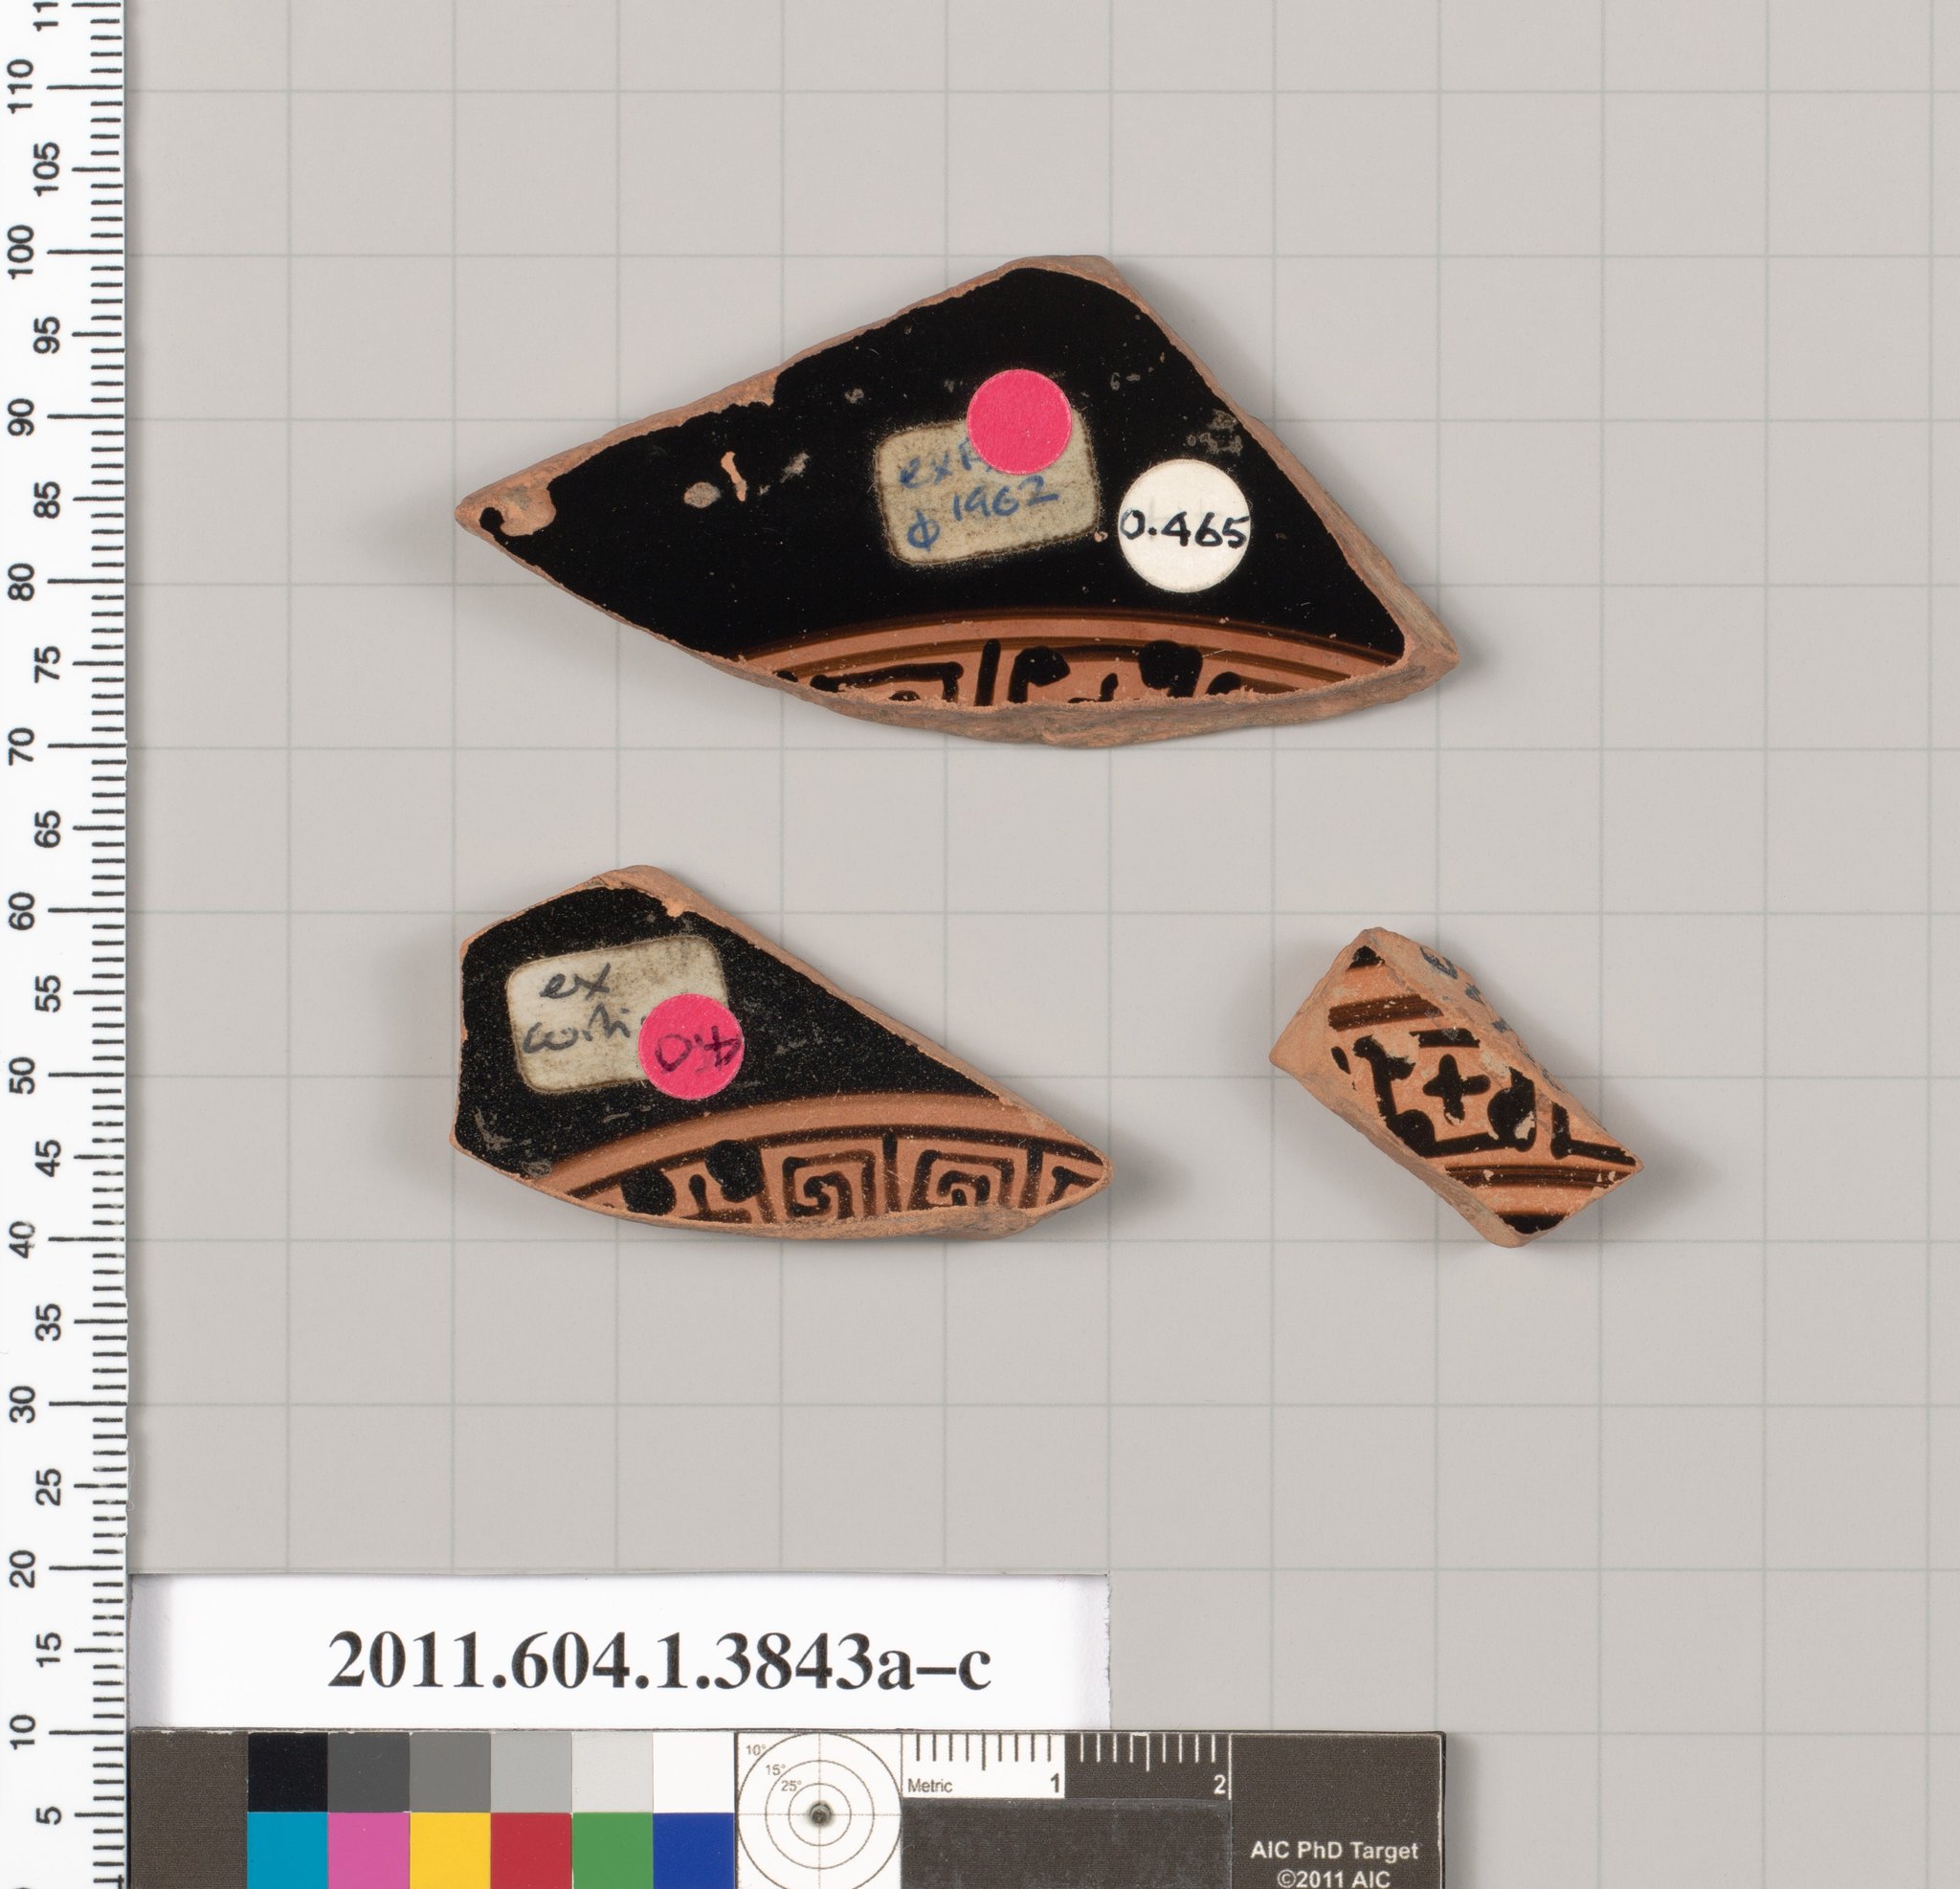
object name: kylix fragment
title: Terracotta fragments of kylikes (drinking cups)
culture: greek, attic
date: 460-440 BCE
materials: terracotta